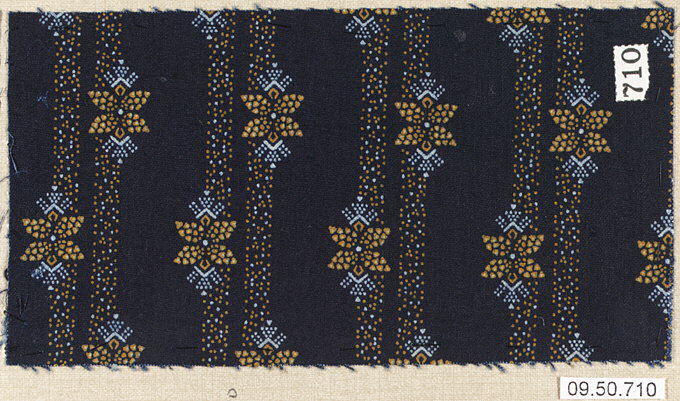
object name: piece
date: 1801-1900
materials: cotton